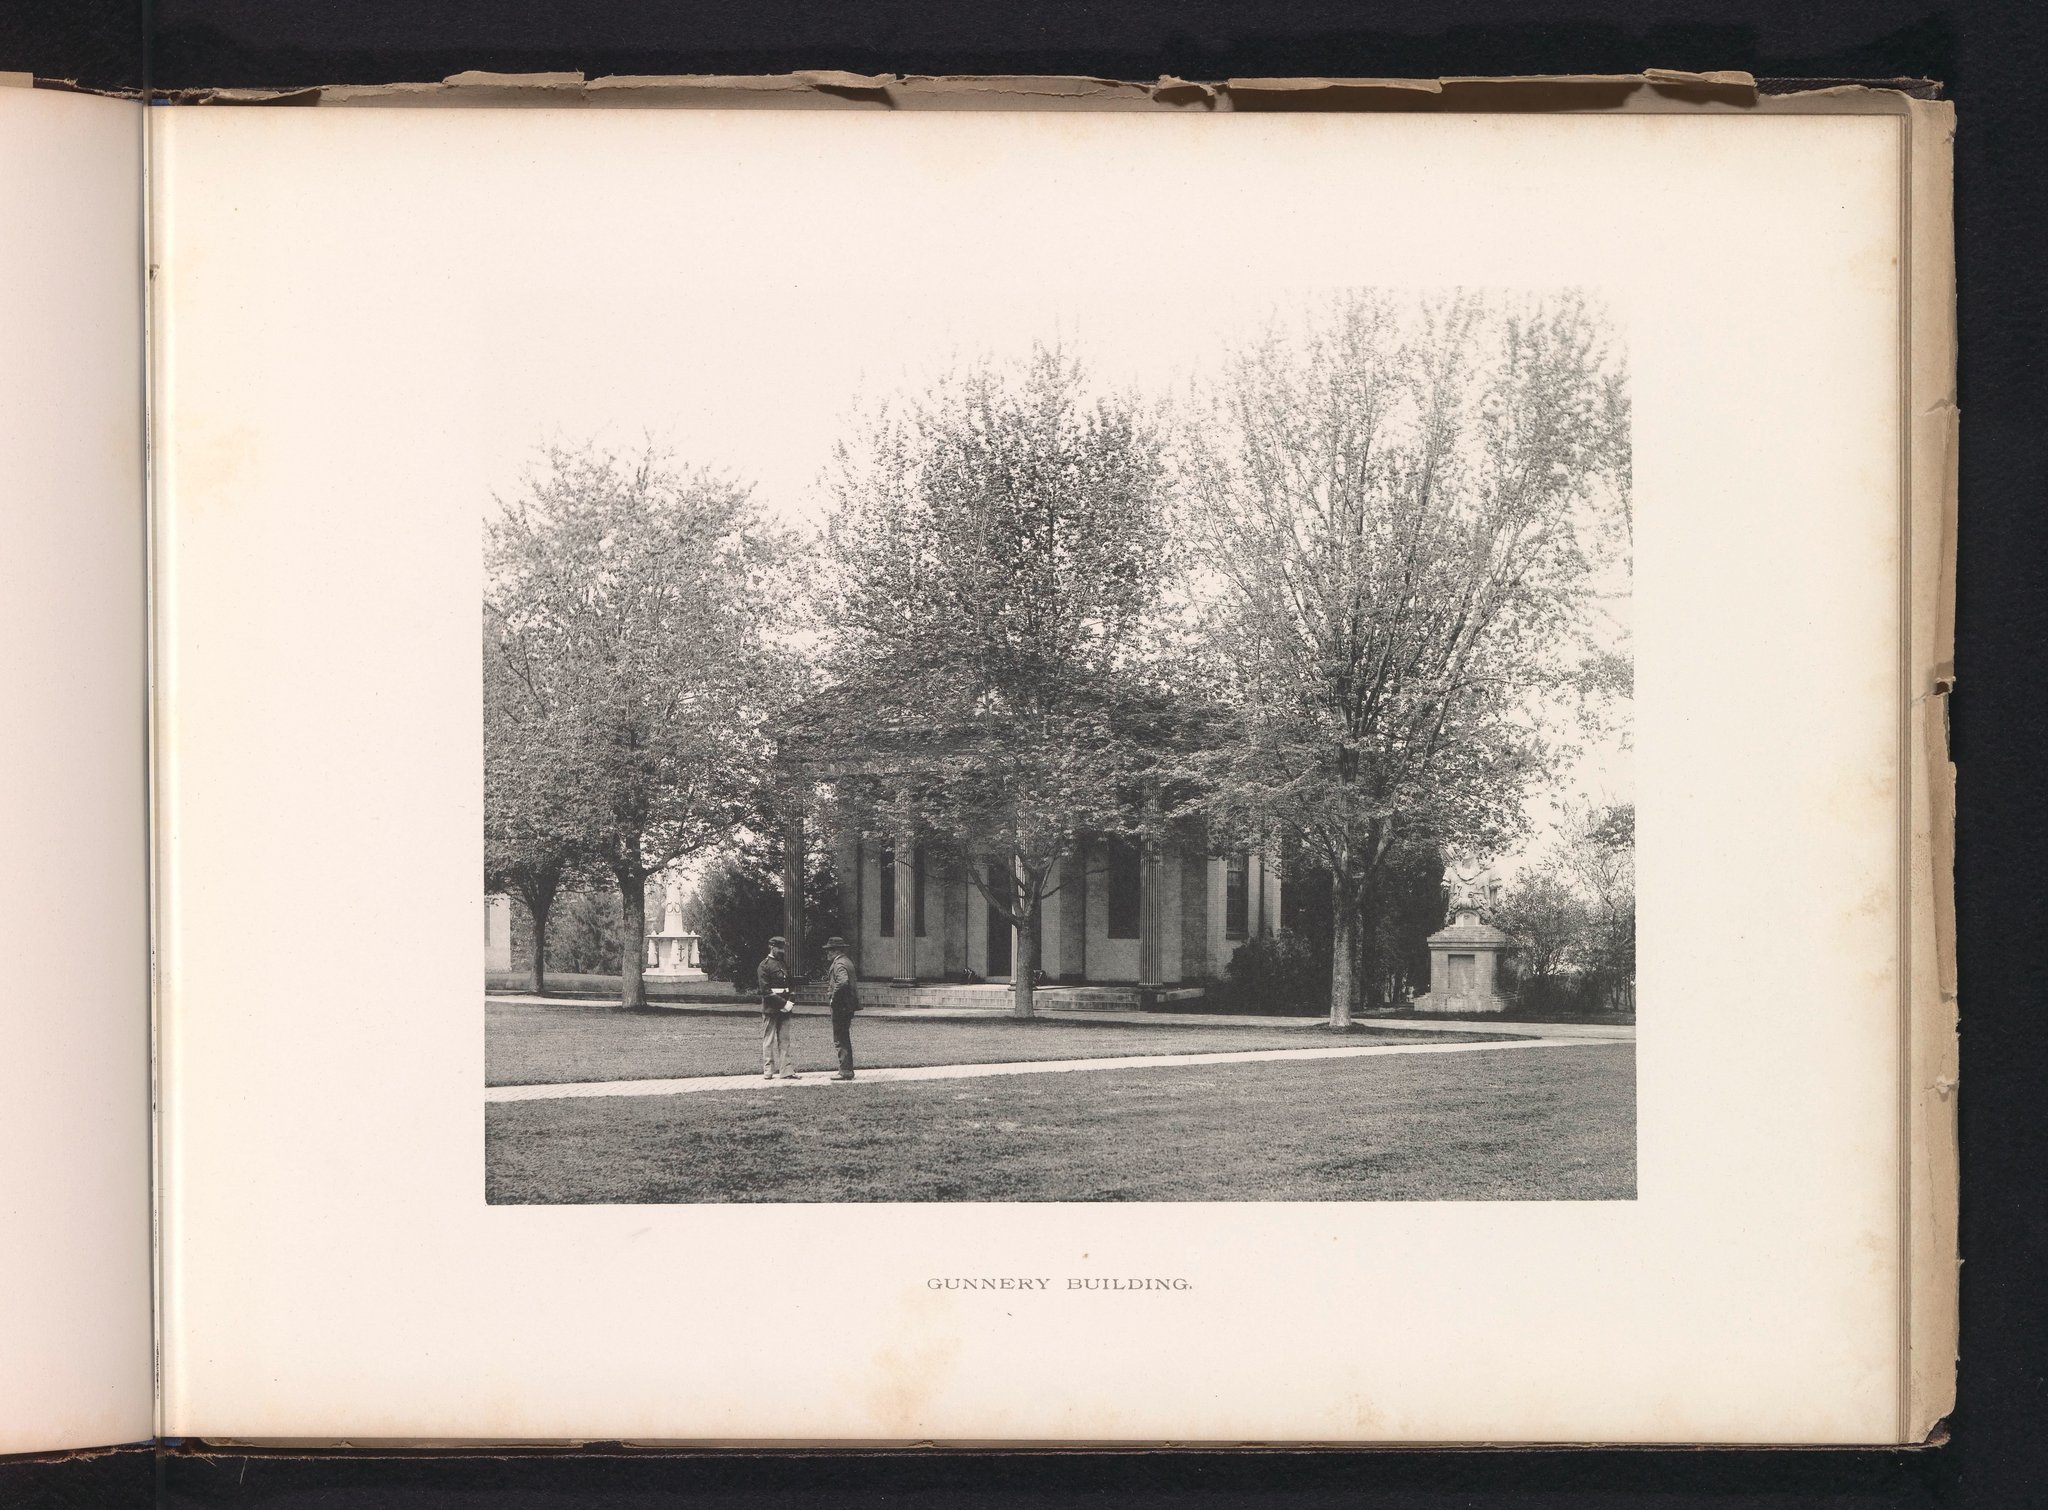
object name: page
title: Gunnery building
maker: edward h. hart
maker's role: publisher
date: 1885-1890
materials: paper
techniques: photograph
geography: united states naval academy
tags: façade (of house or building), ammunition store, arsenal